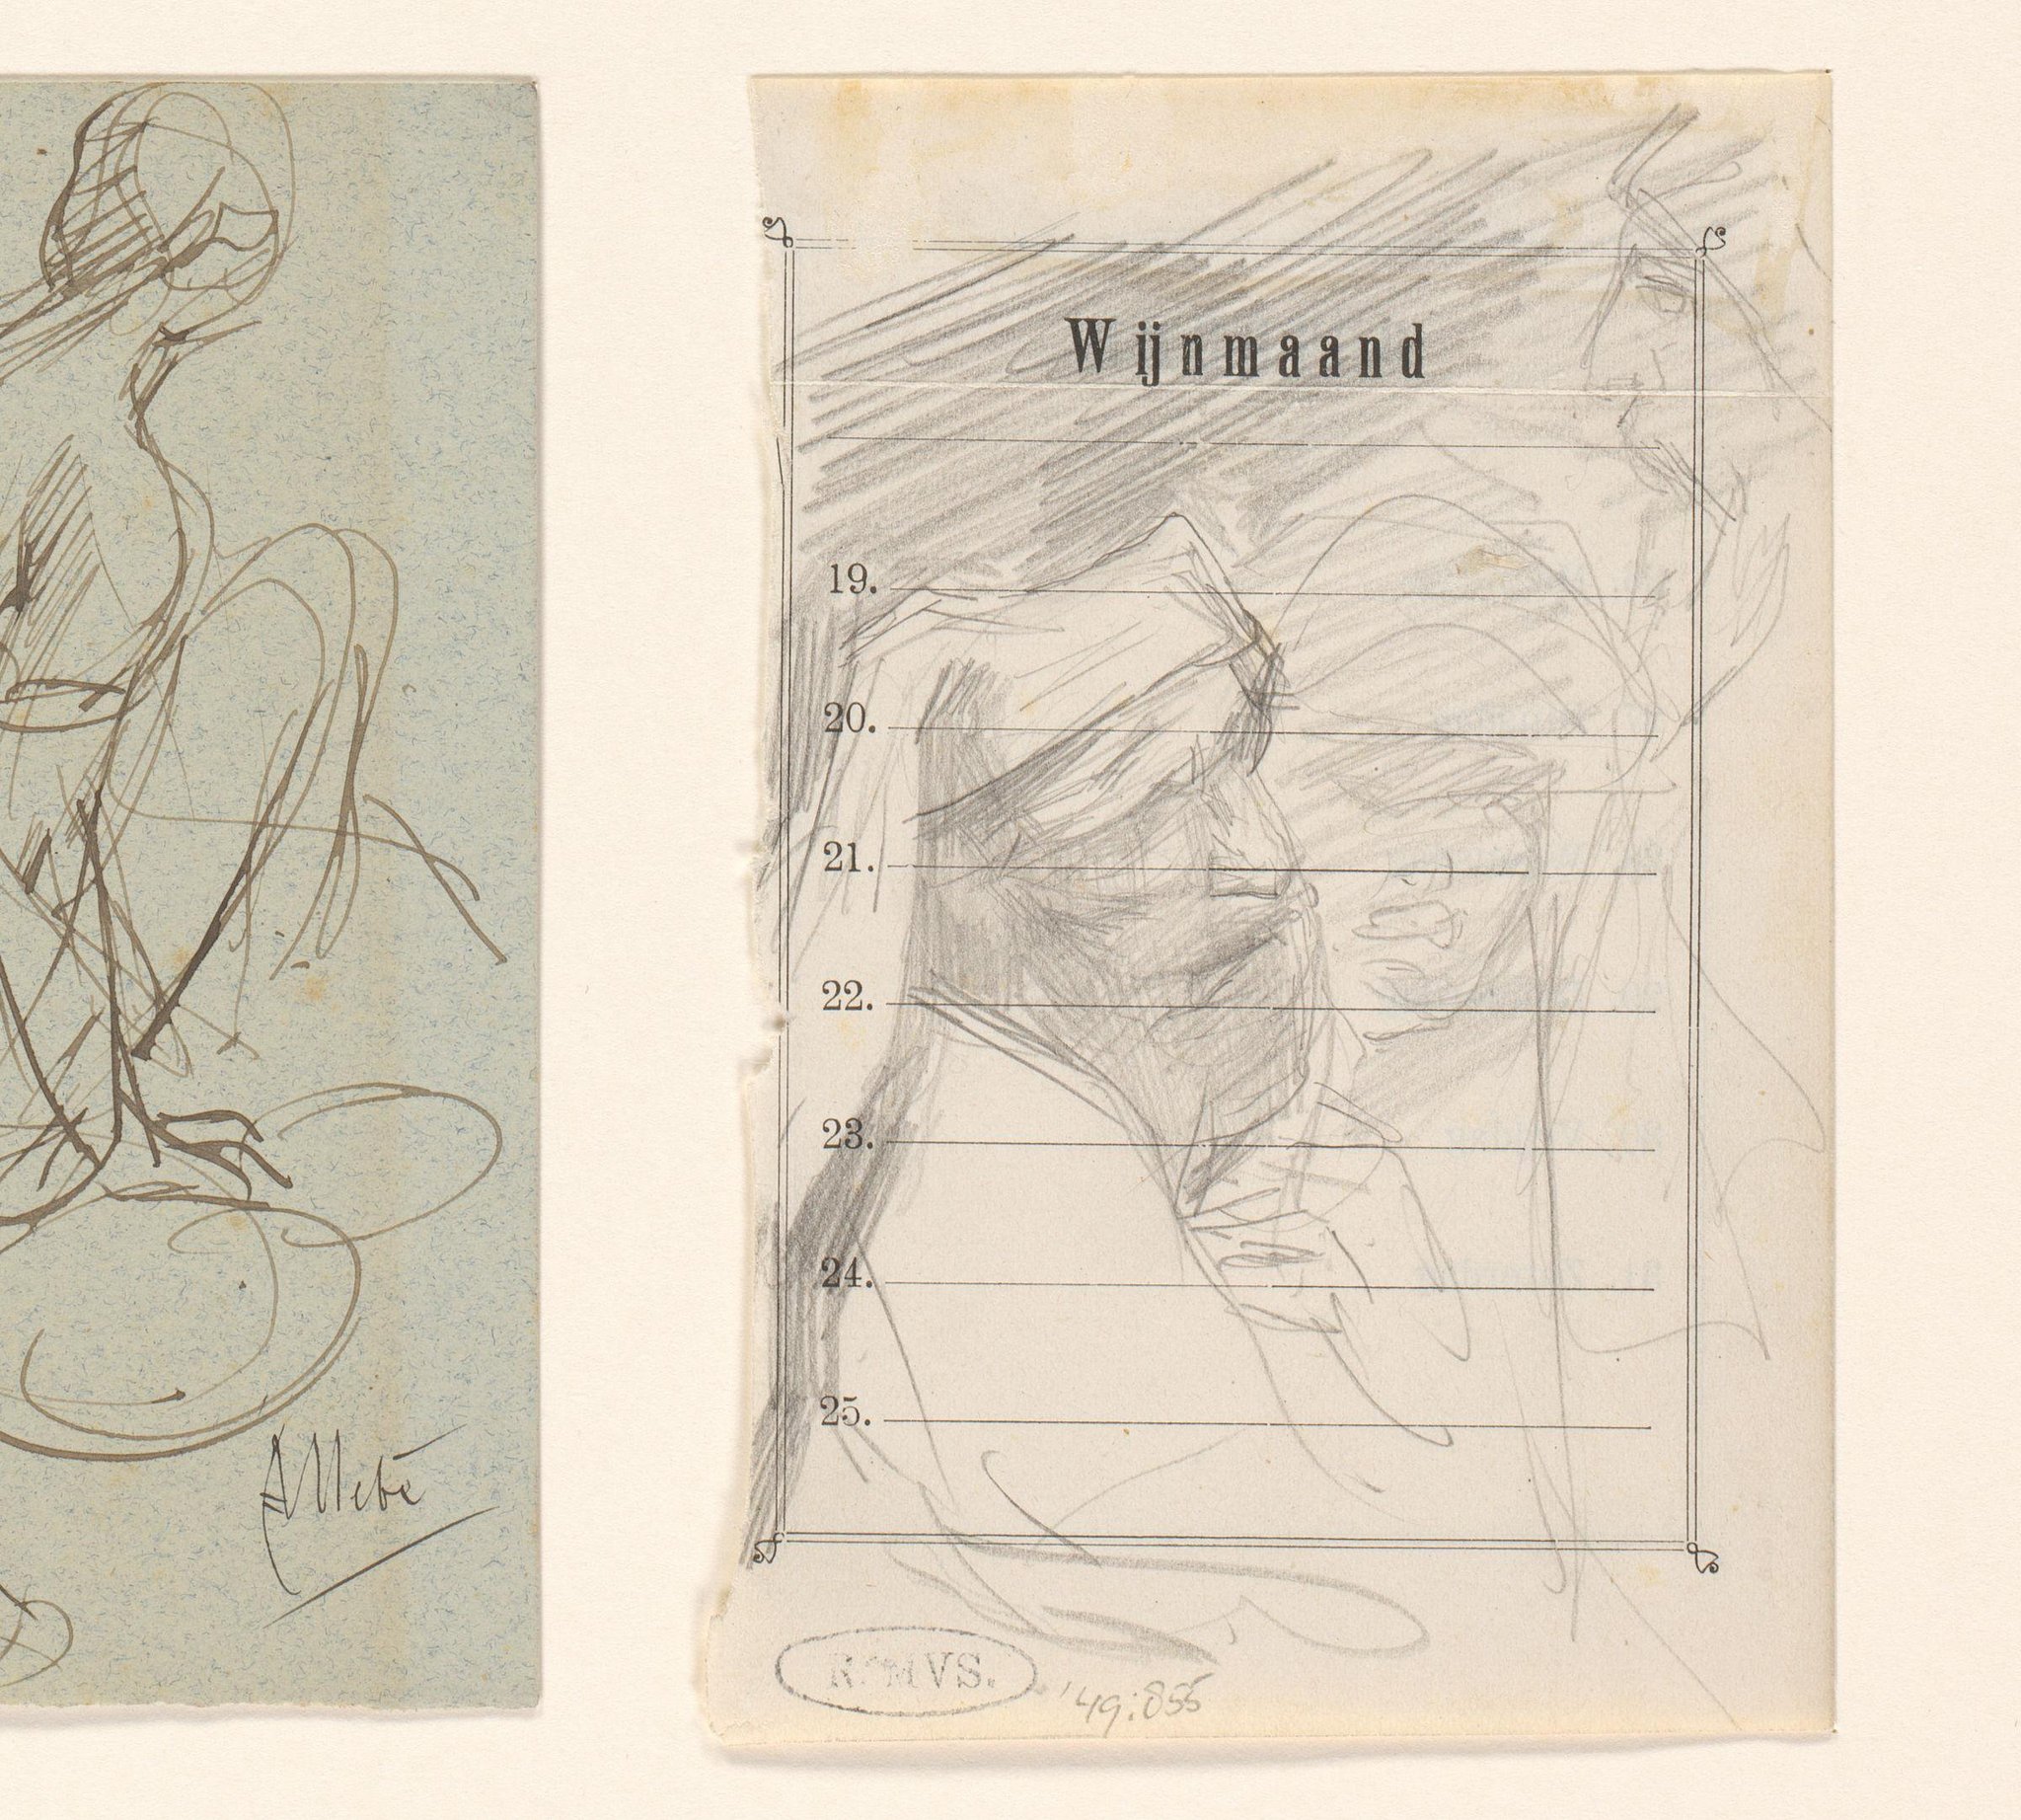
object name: drawing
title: Schets van twee hoofden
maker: august allebé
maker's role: draughtsman, print maker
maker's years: 1838-1927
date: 1848-1927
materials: paper, pencil